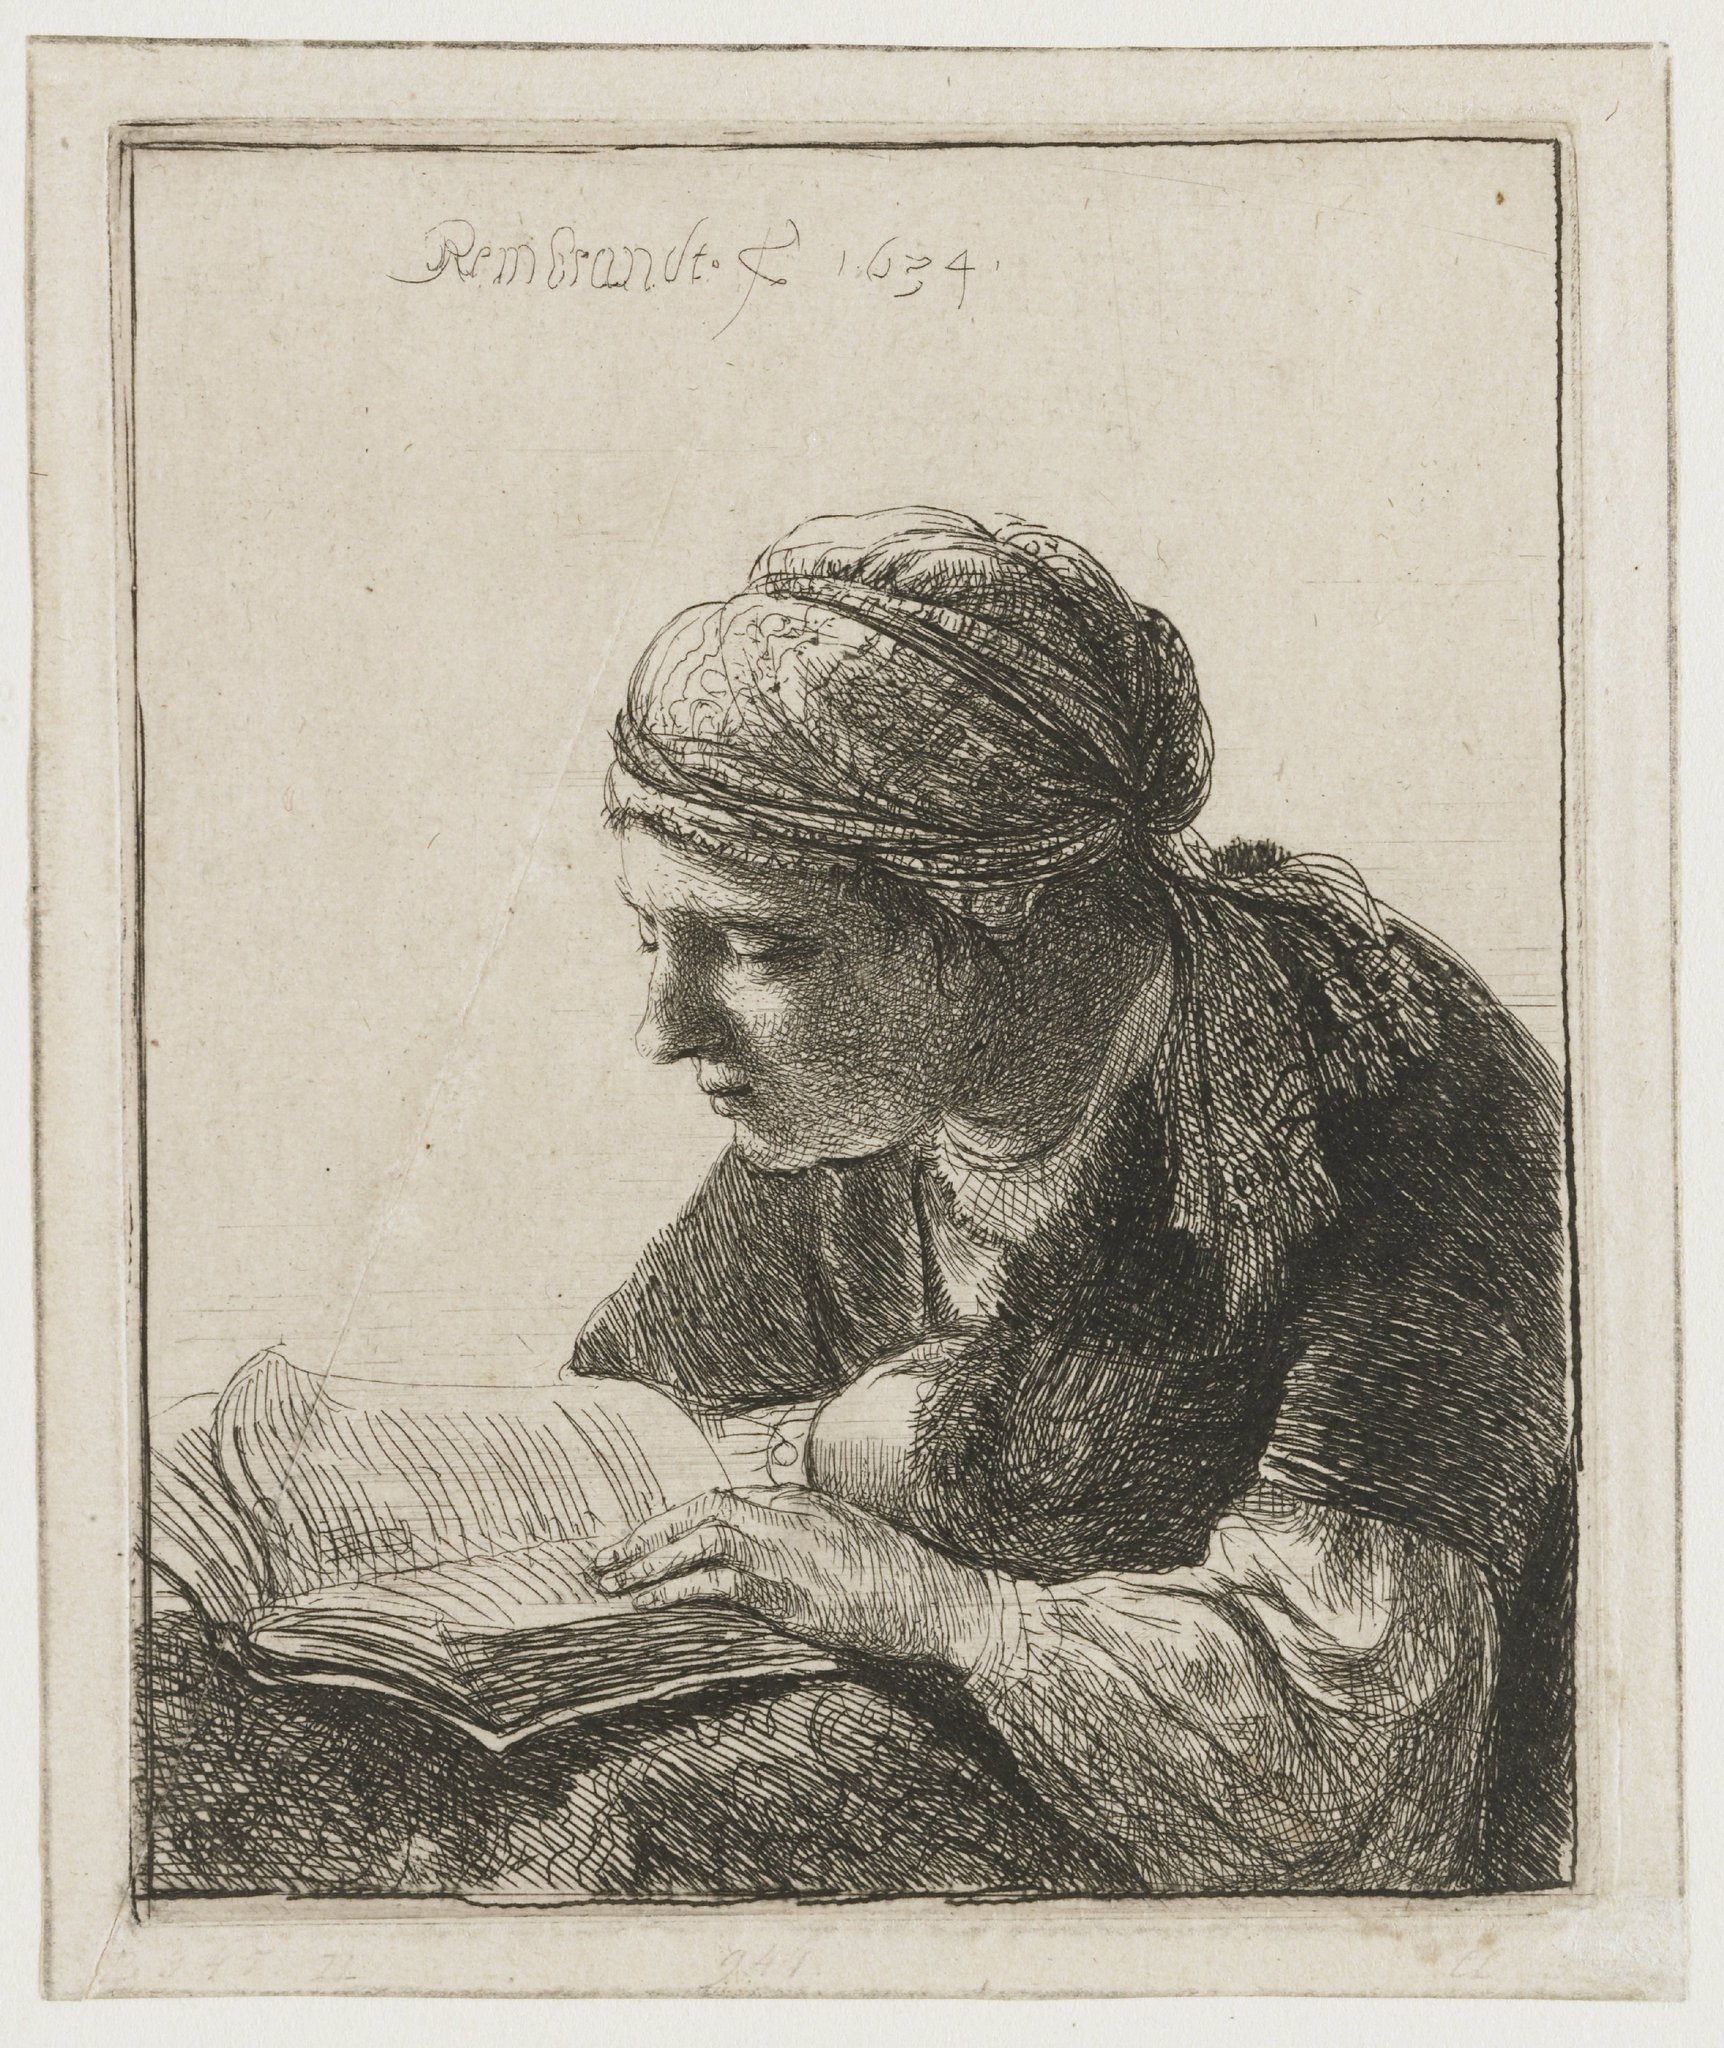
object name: print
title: Woman reading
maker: rembrandt van rijn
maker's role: draughtsman, painter, print maker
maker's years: 1606-1669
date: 1634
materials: paper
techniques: etching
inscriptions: collector's mark: Lugt 240, signature and date: ‘Rembrandt f 1634’